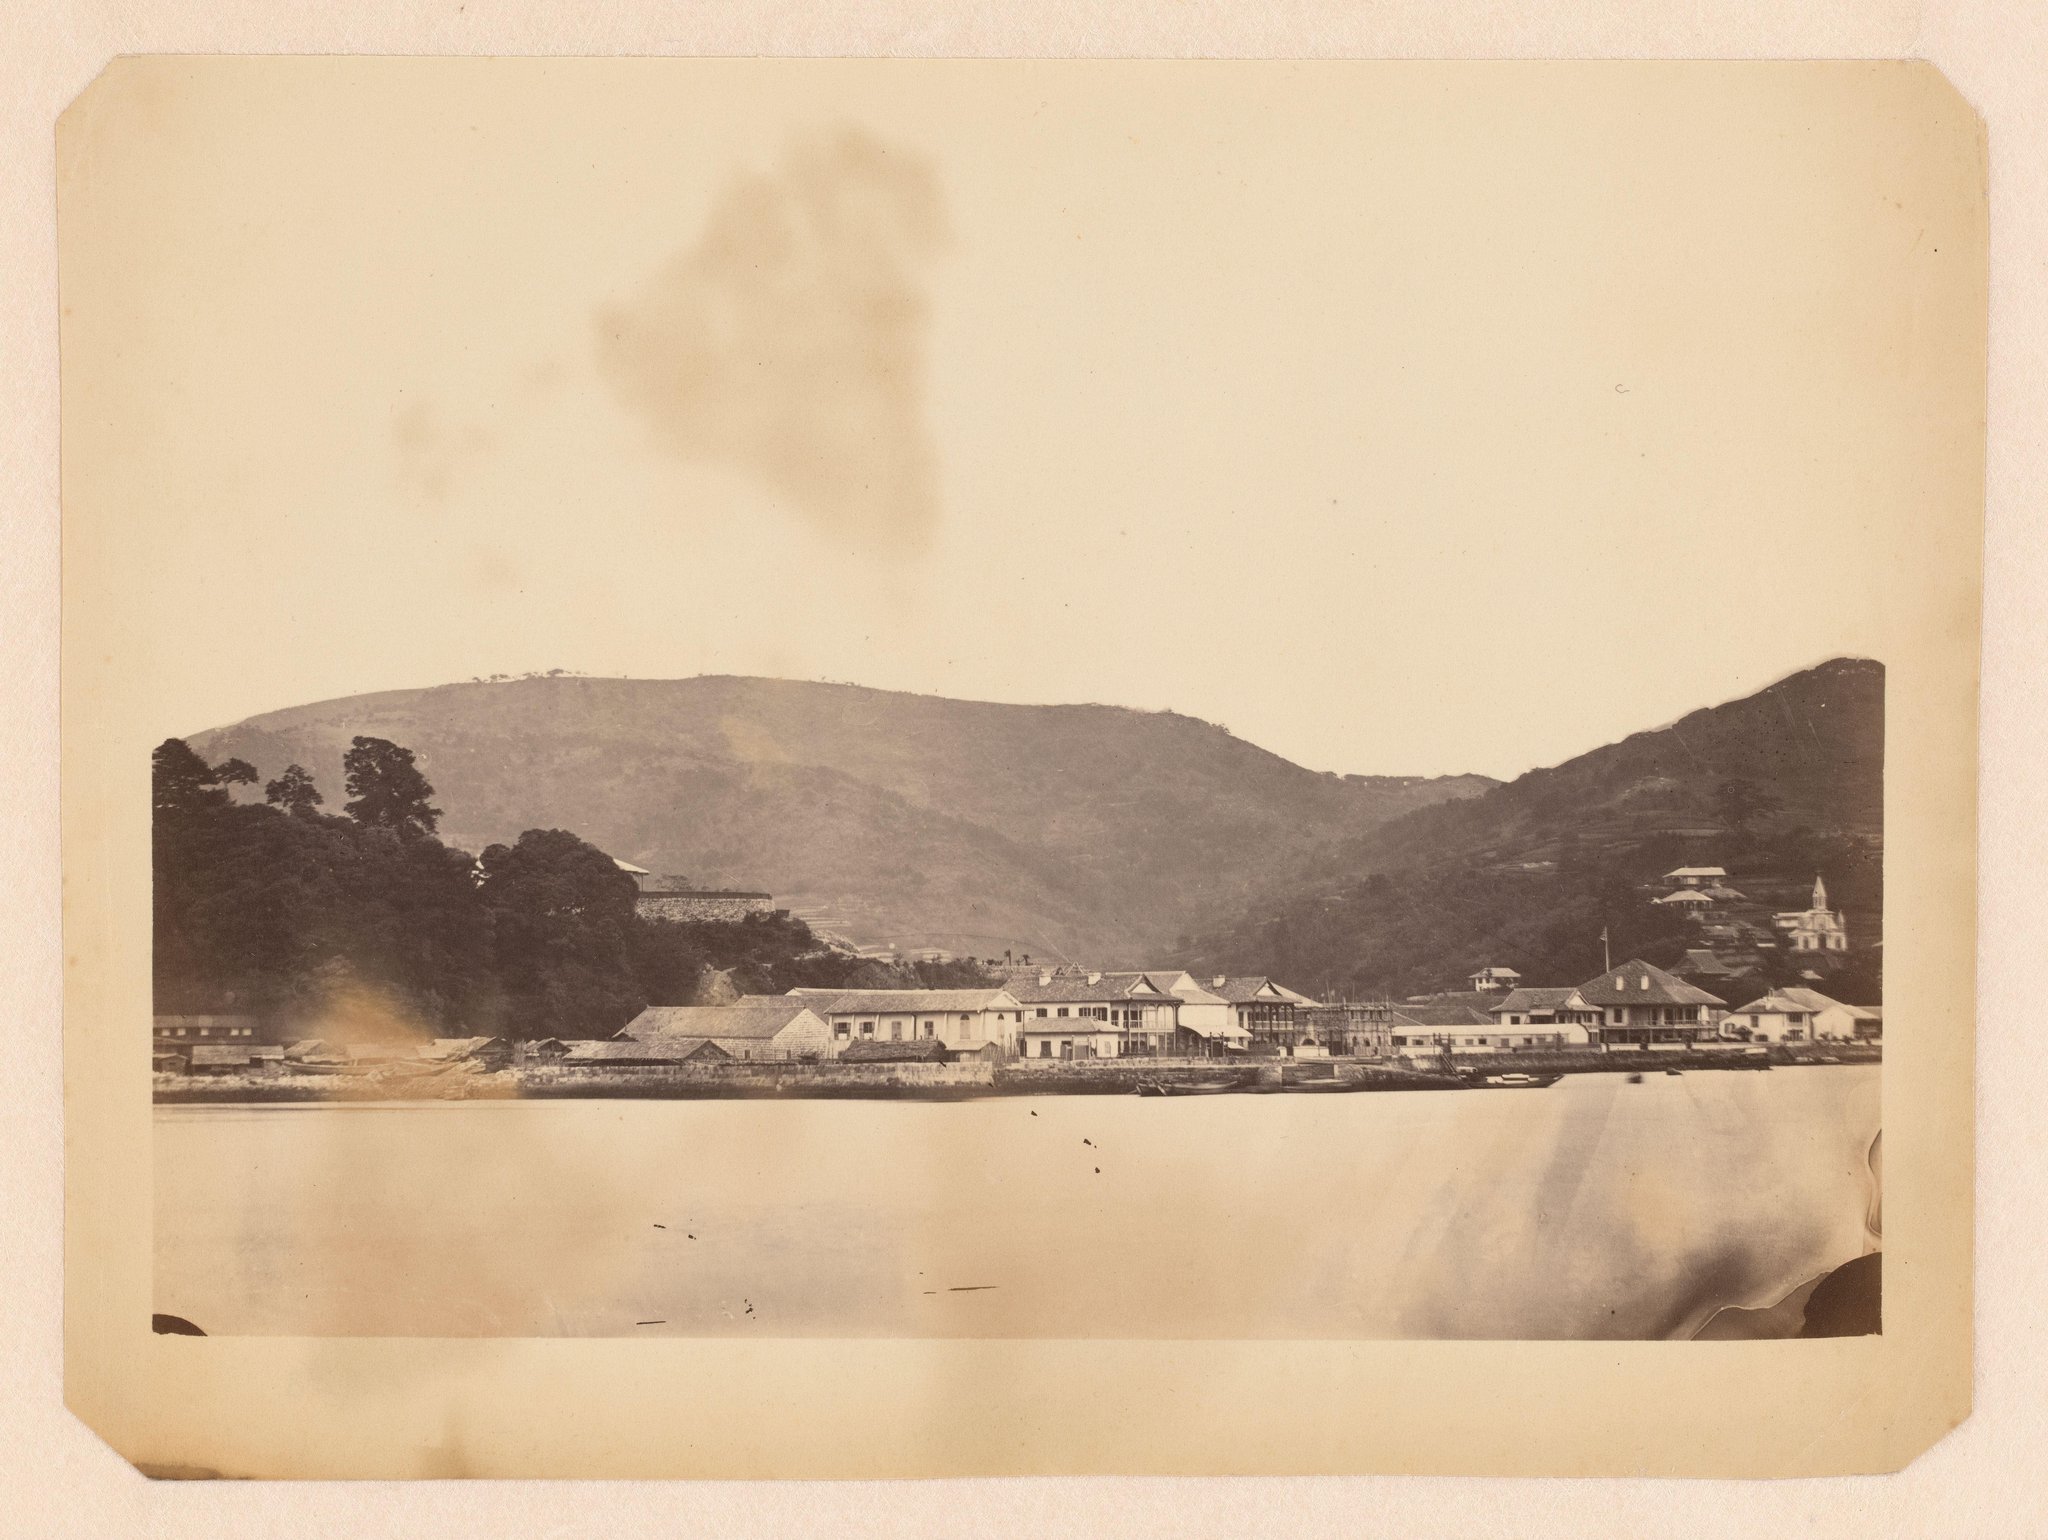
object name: photograph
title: Oura, Nagasaki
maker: antoon bauduin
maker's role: amateurfotograaf, hoogleraar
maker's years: 1820-1885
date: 1862-1866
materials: paper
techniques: albumen print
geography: japan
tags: gulf, bay, japan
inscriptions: number: ‘E8’